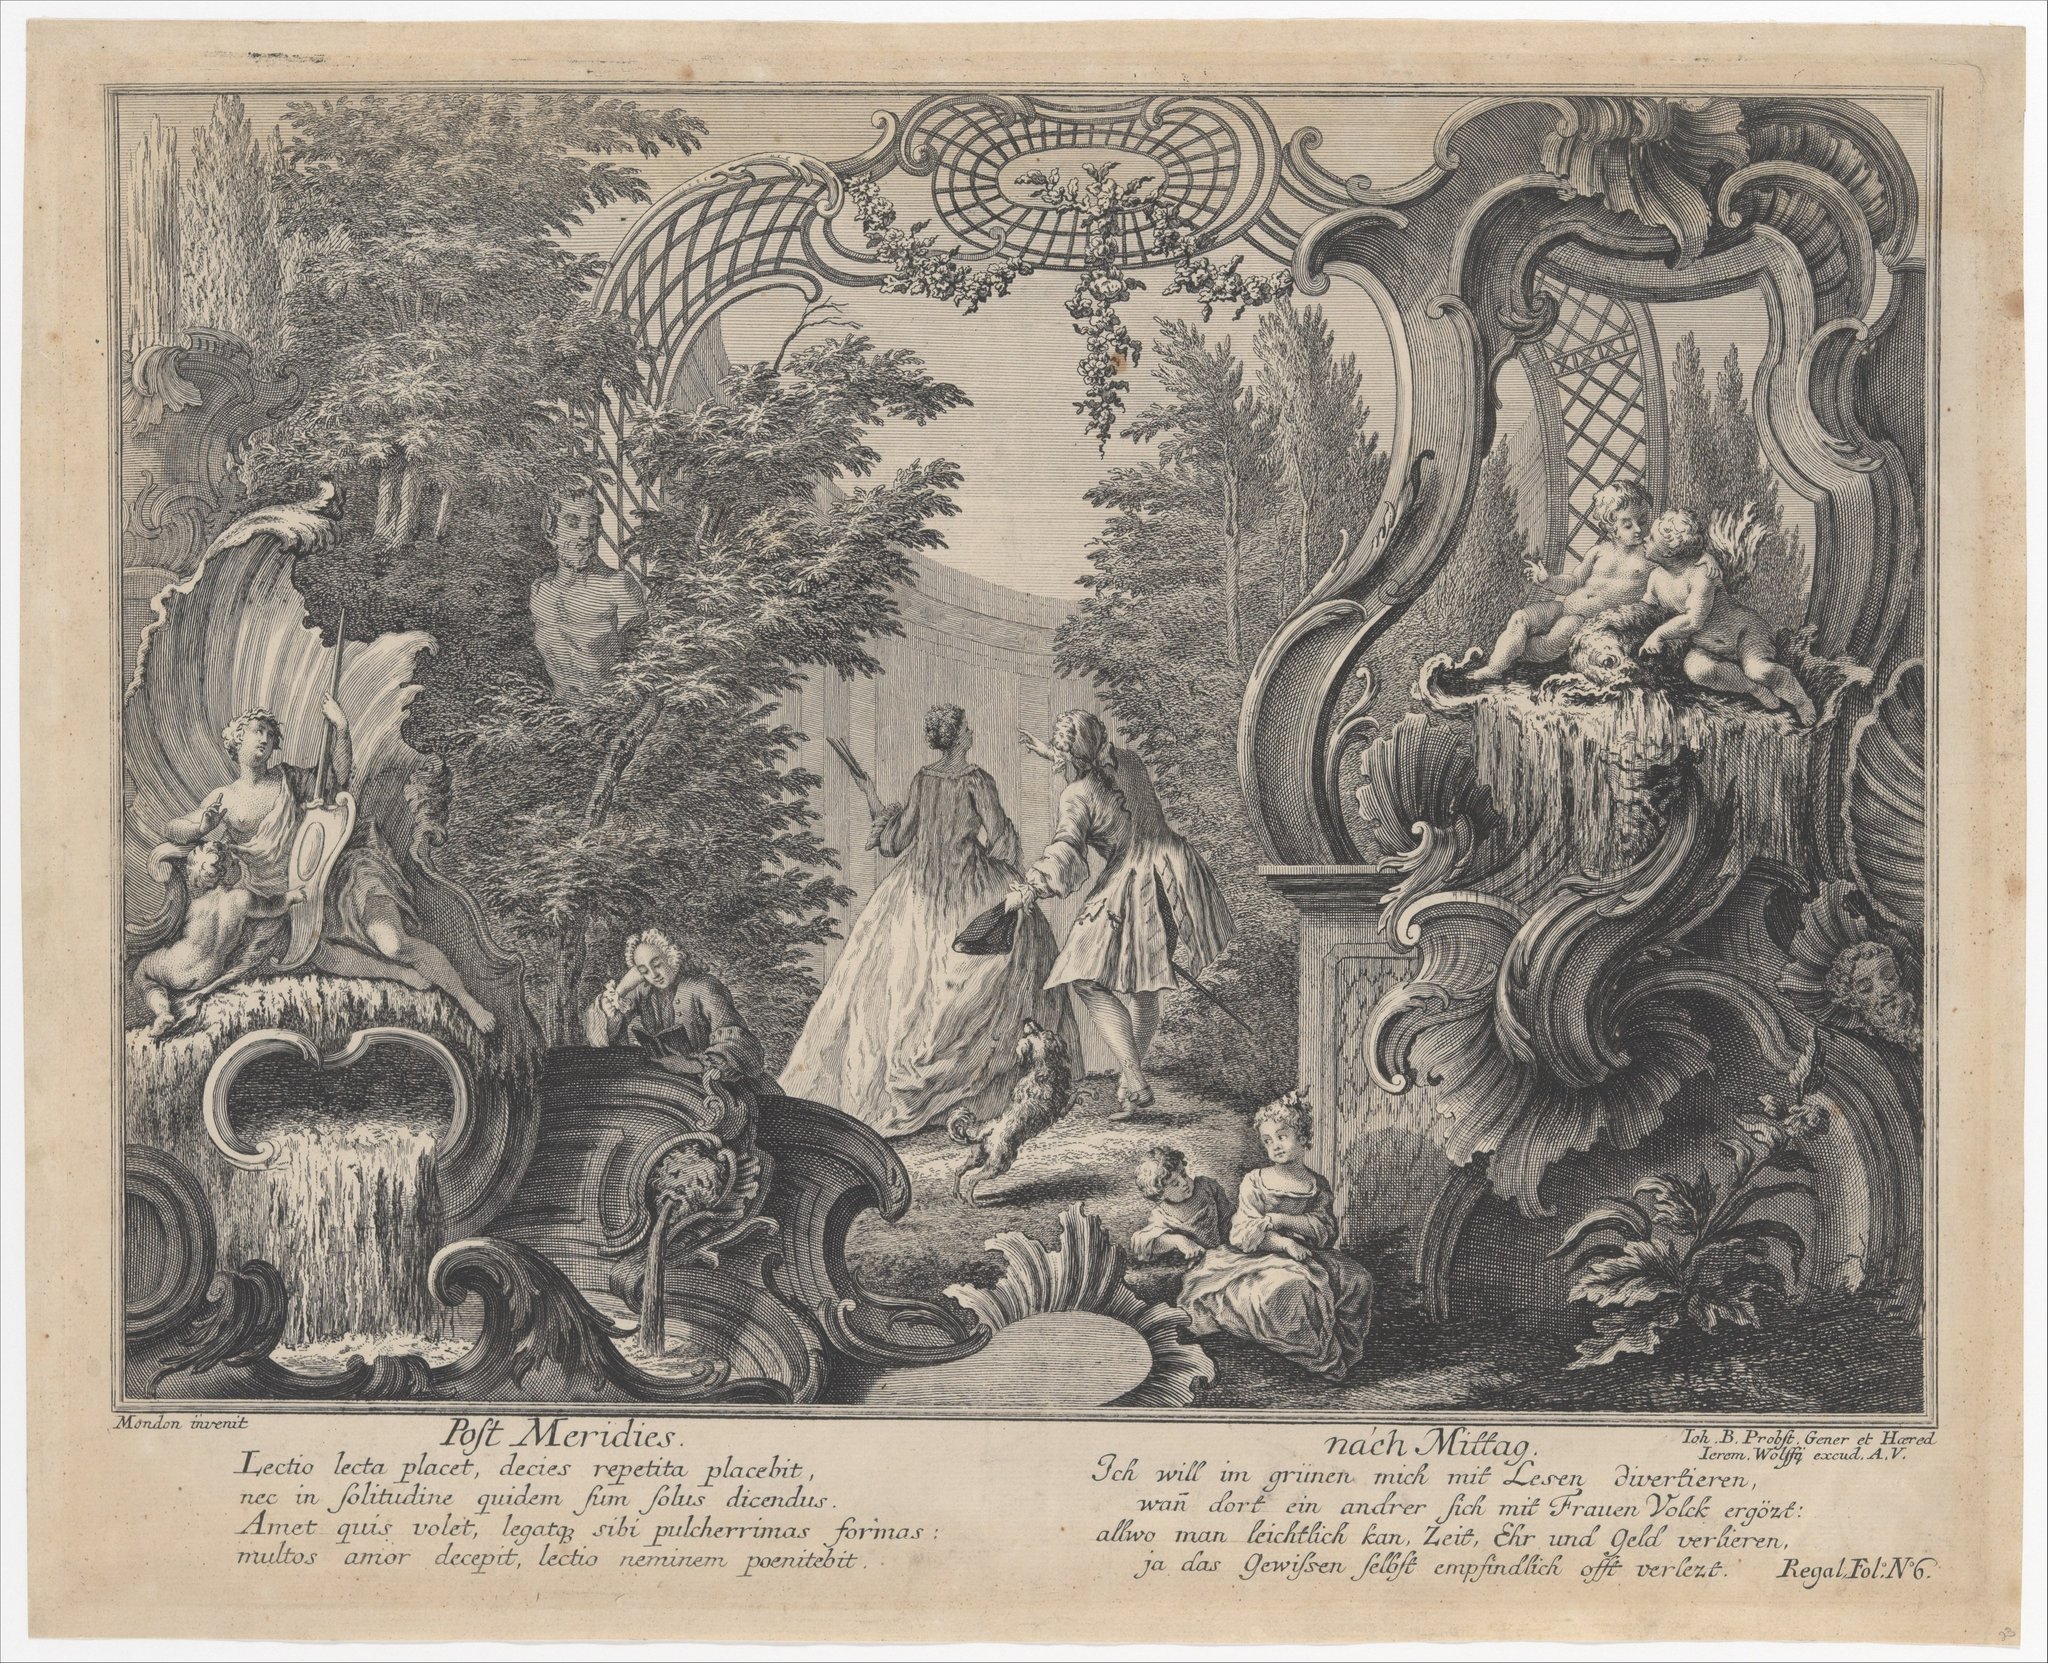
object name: print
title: Post Meridies, from the Hours of the Day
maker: jean mondon le fils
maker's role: artist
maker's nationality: french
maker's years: 1736-1745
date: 1736-1745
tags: boys,girls,men,women,dogs